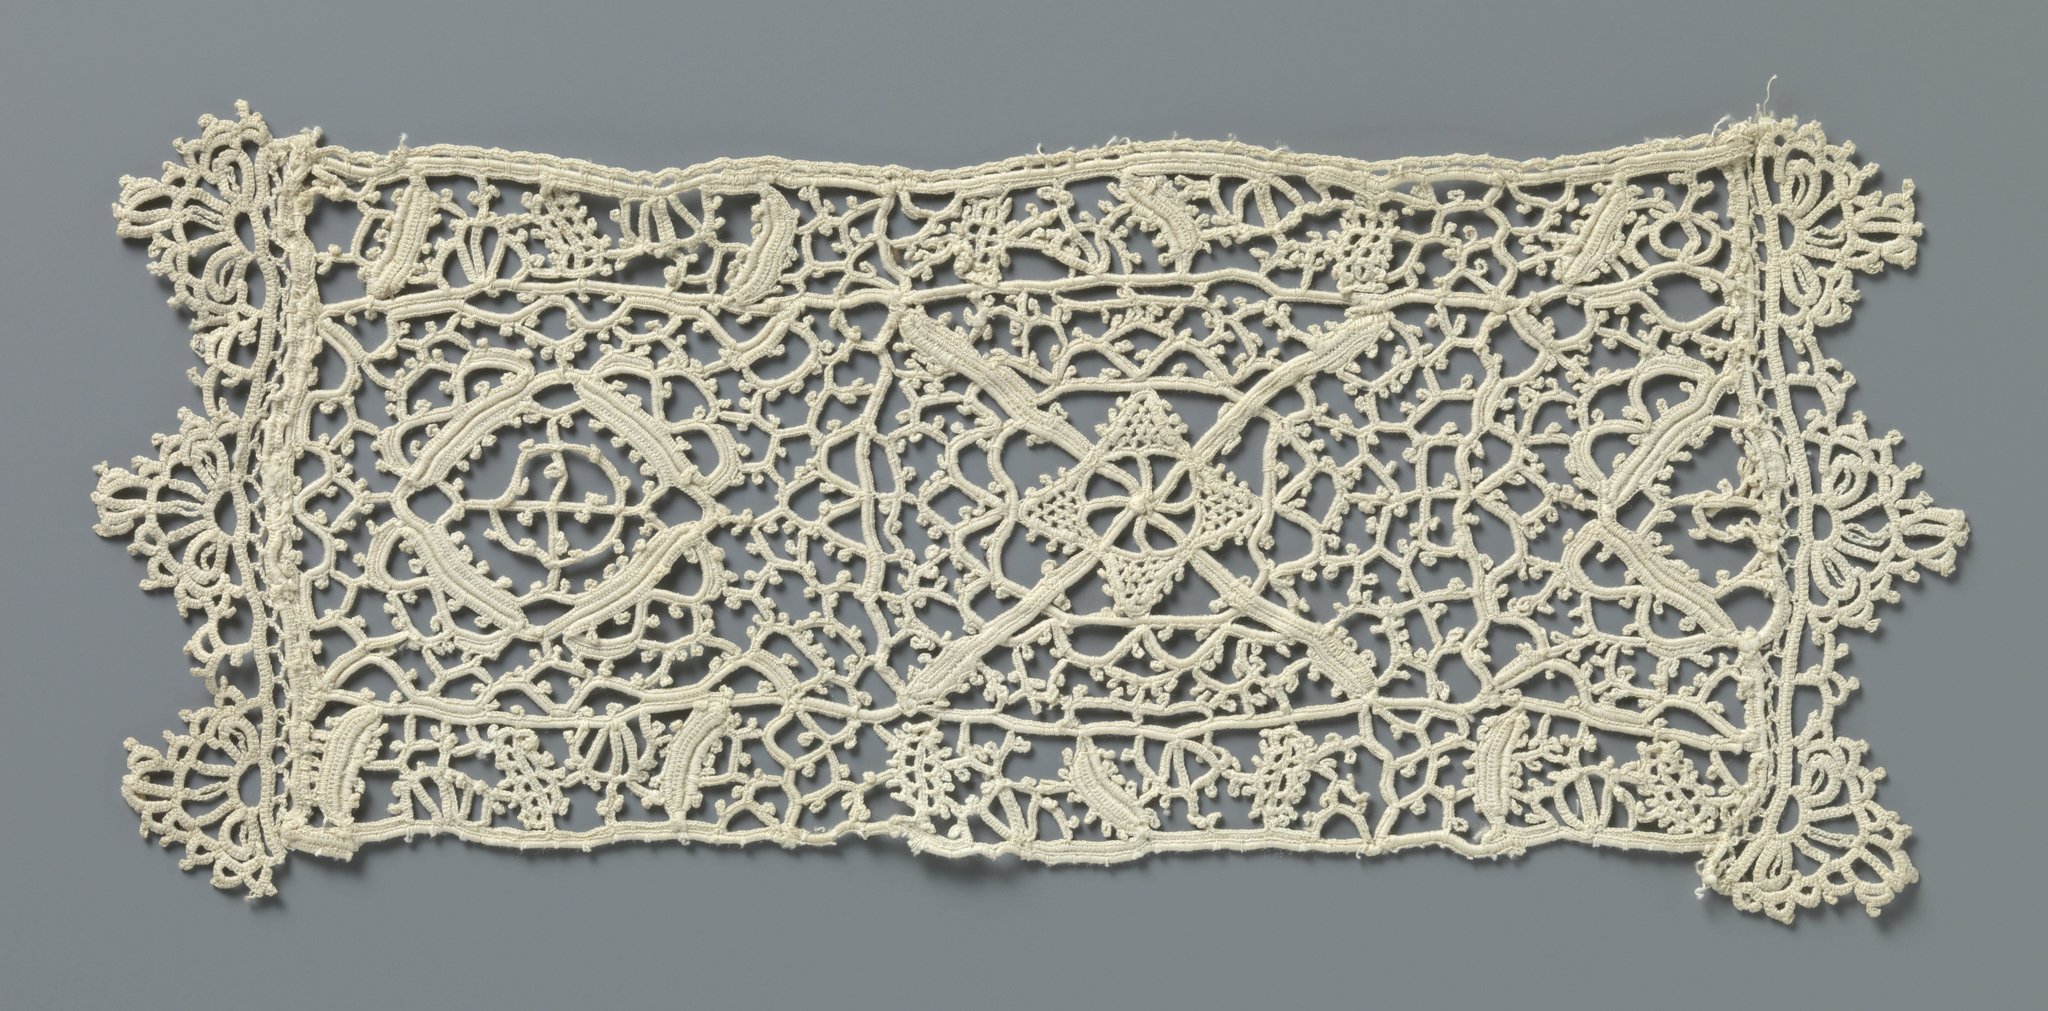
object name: strip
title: Strook gehaakte kant met reticella motieven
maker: Anonymous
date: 1890-1909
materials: cotton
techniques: crocheted lace, irish crochet lace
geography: ireland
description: Het is een aanname dat deze Ierse gehaakte kant ook daadwerkelijk in Ierland is gemaakt. Ierse gehaakte kant kent zijn oorsprong rond 1760 en kwam vanaf 1840 in ontwikkeling. Aangezien volgens Martine Bruggeman (Kant in Europa) de Ierse haakindustrie aan het eind van de 19e eeuw gereorganiseerd werd en in populariteit groeide, is het hier beschreven stuk gedateerd rond 1890, tot 1909 vanwege de datering in het eerste decennium van populariteit van Ierse gehaakte kant volgens het Kantlexicon (Johan Coene).